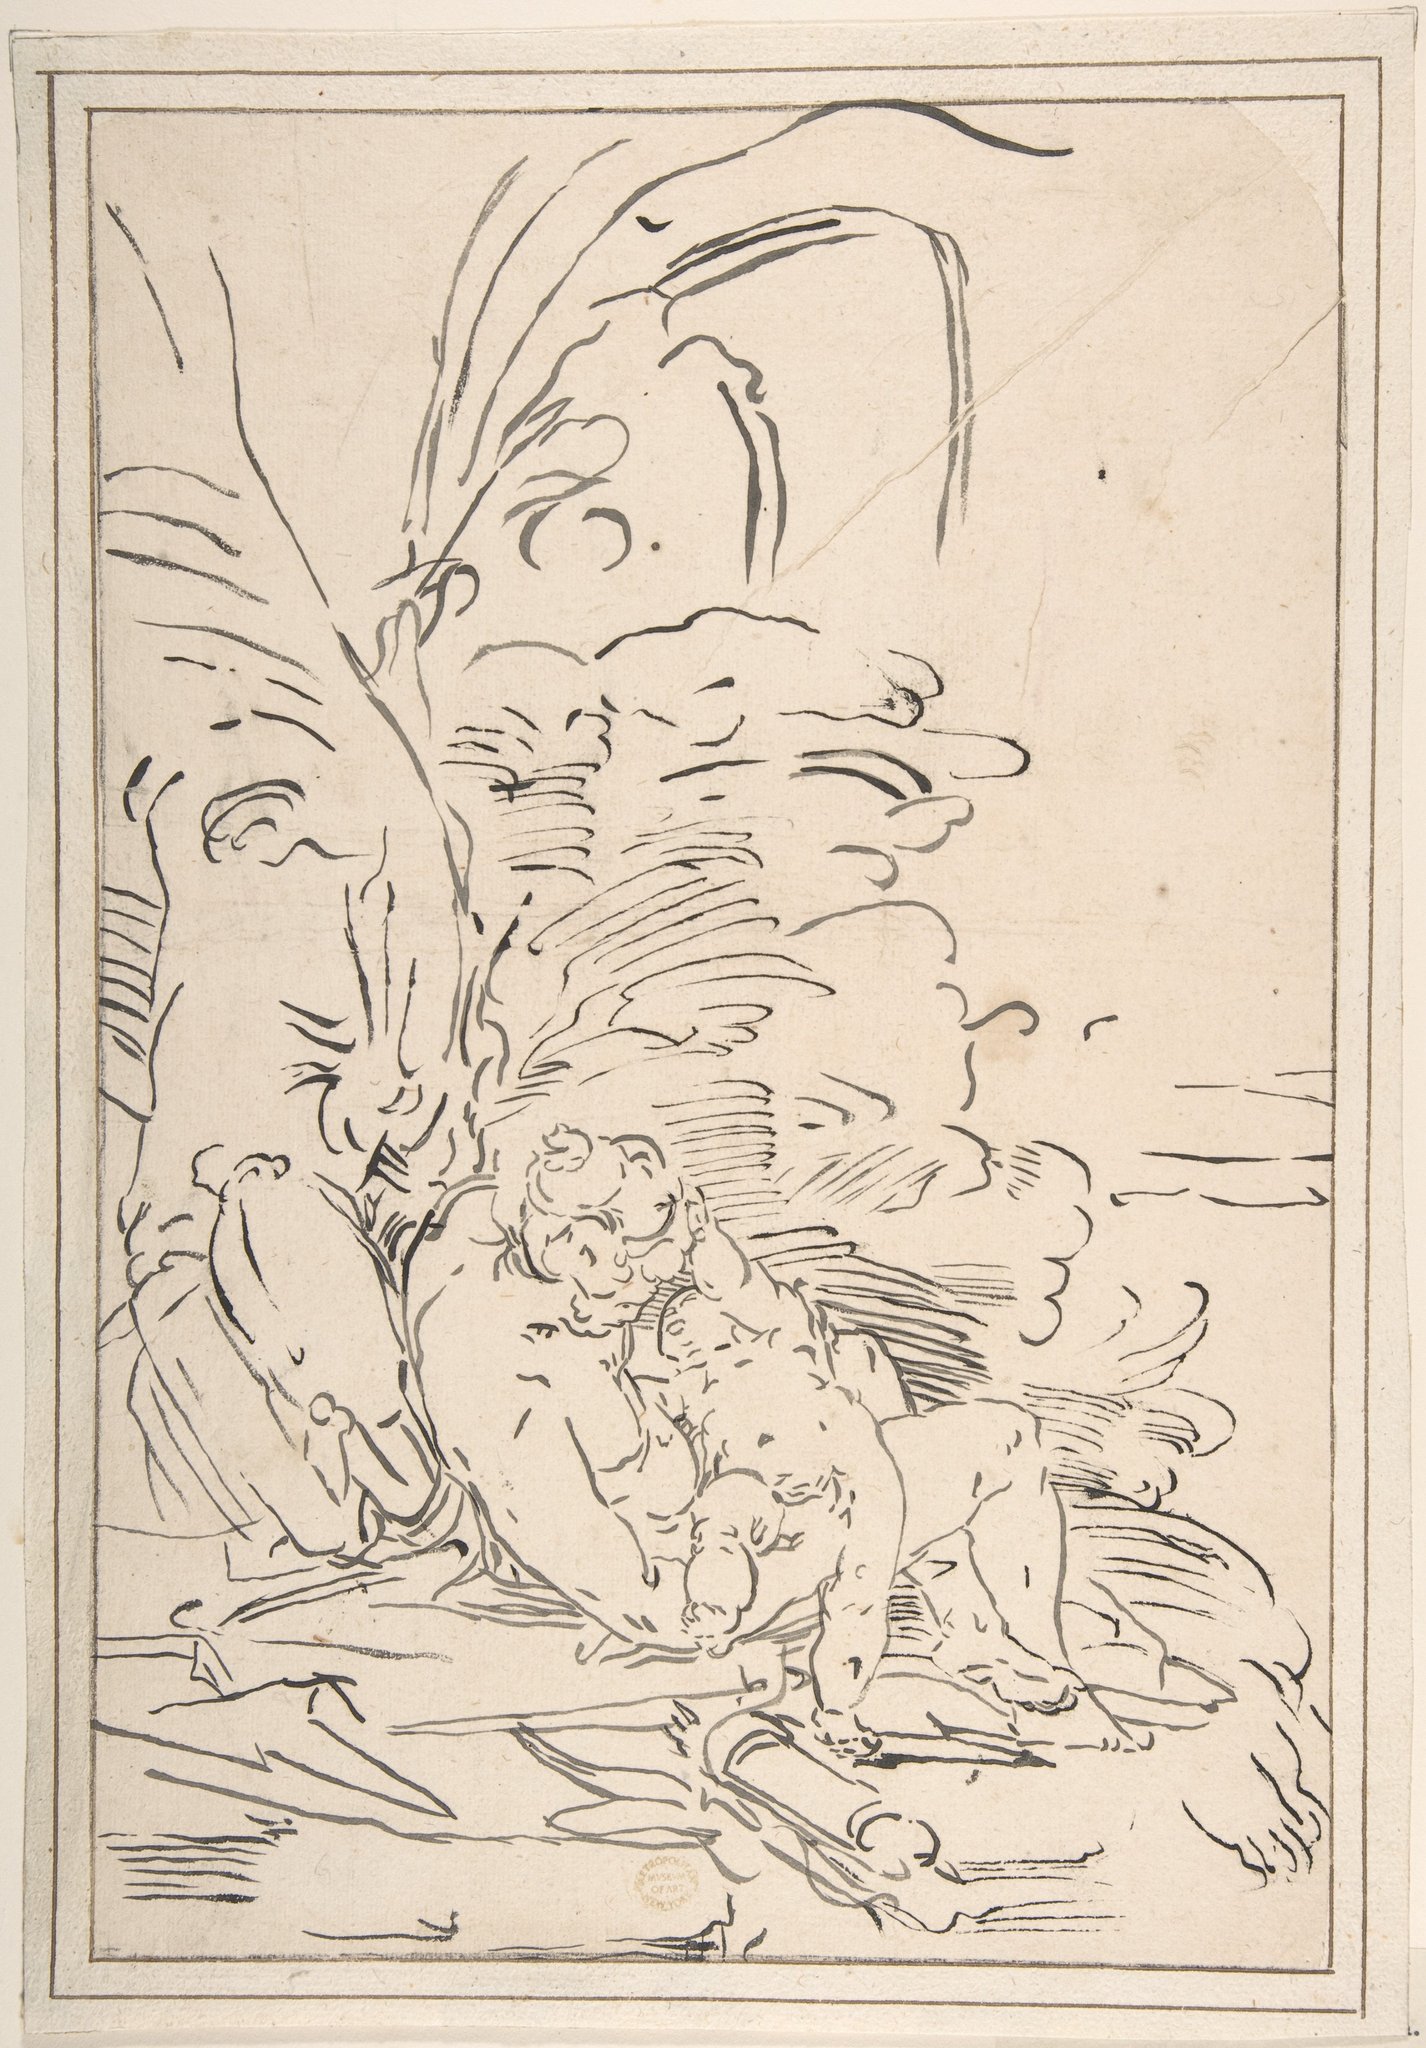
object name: drawing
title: Venus and Cupid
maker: luca cambiaso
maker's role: artist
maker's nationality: italian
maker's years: 1527-1585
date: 1527-1585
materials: ink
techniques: pen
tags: cupid,venus